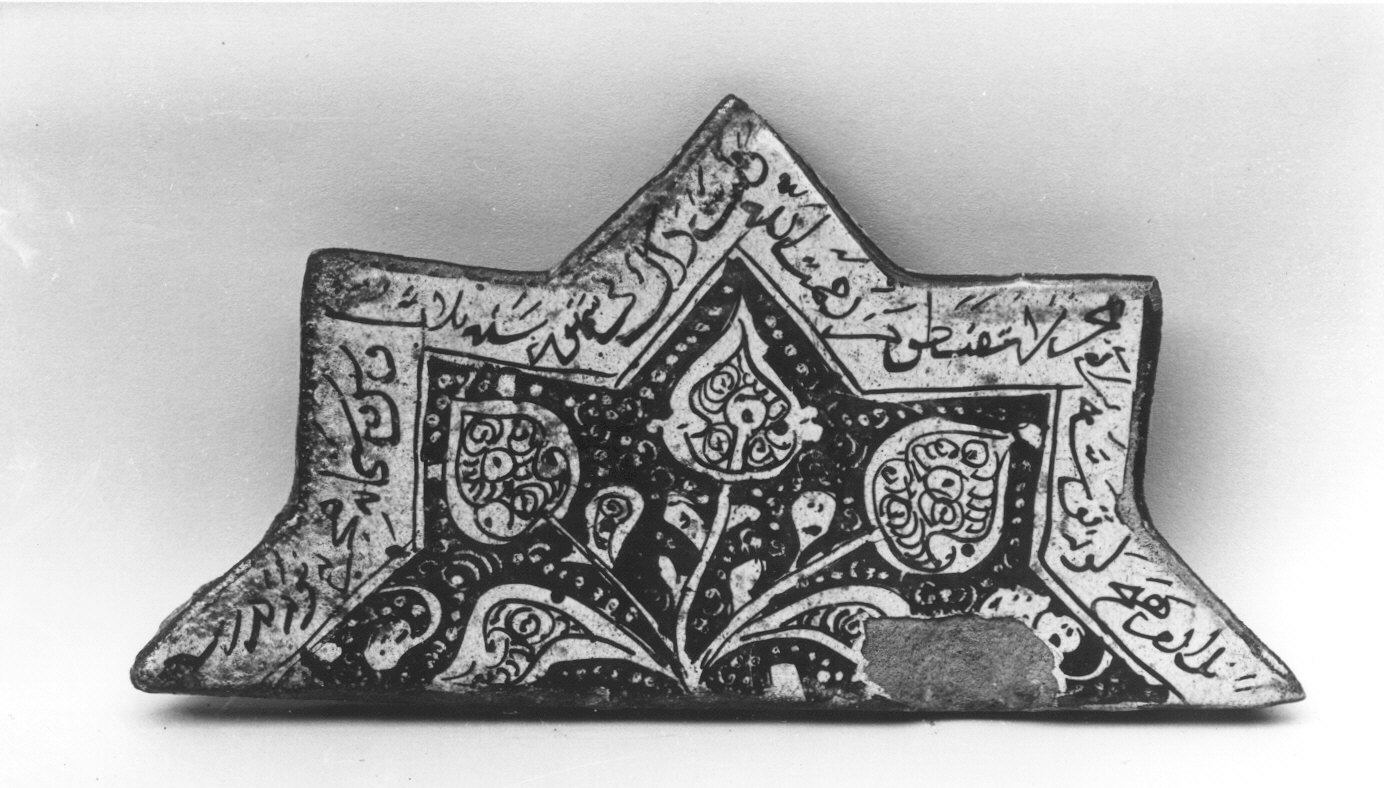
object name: tile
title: Star-Shaped Tile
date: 1201-1300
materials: cobalt, glaze, stonepaste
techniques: luster painting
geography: iran